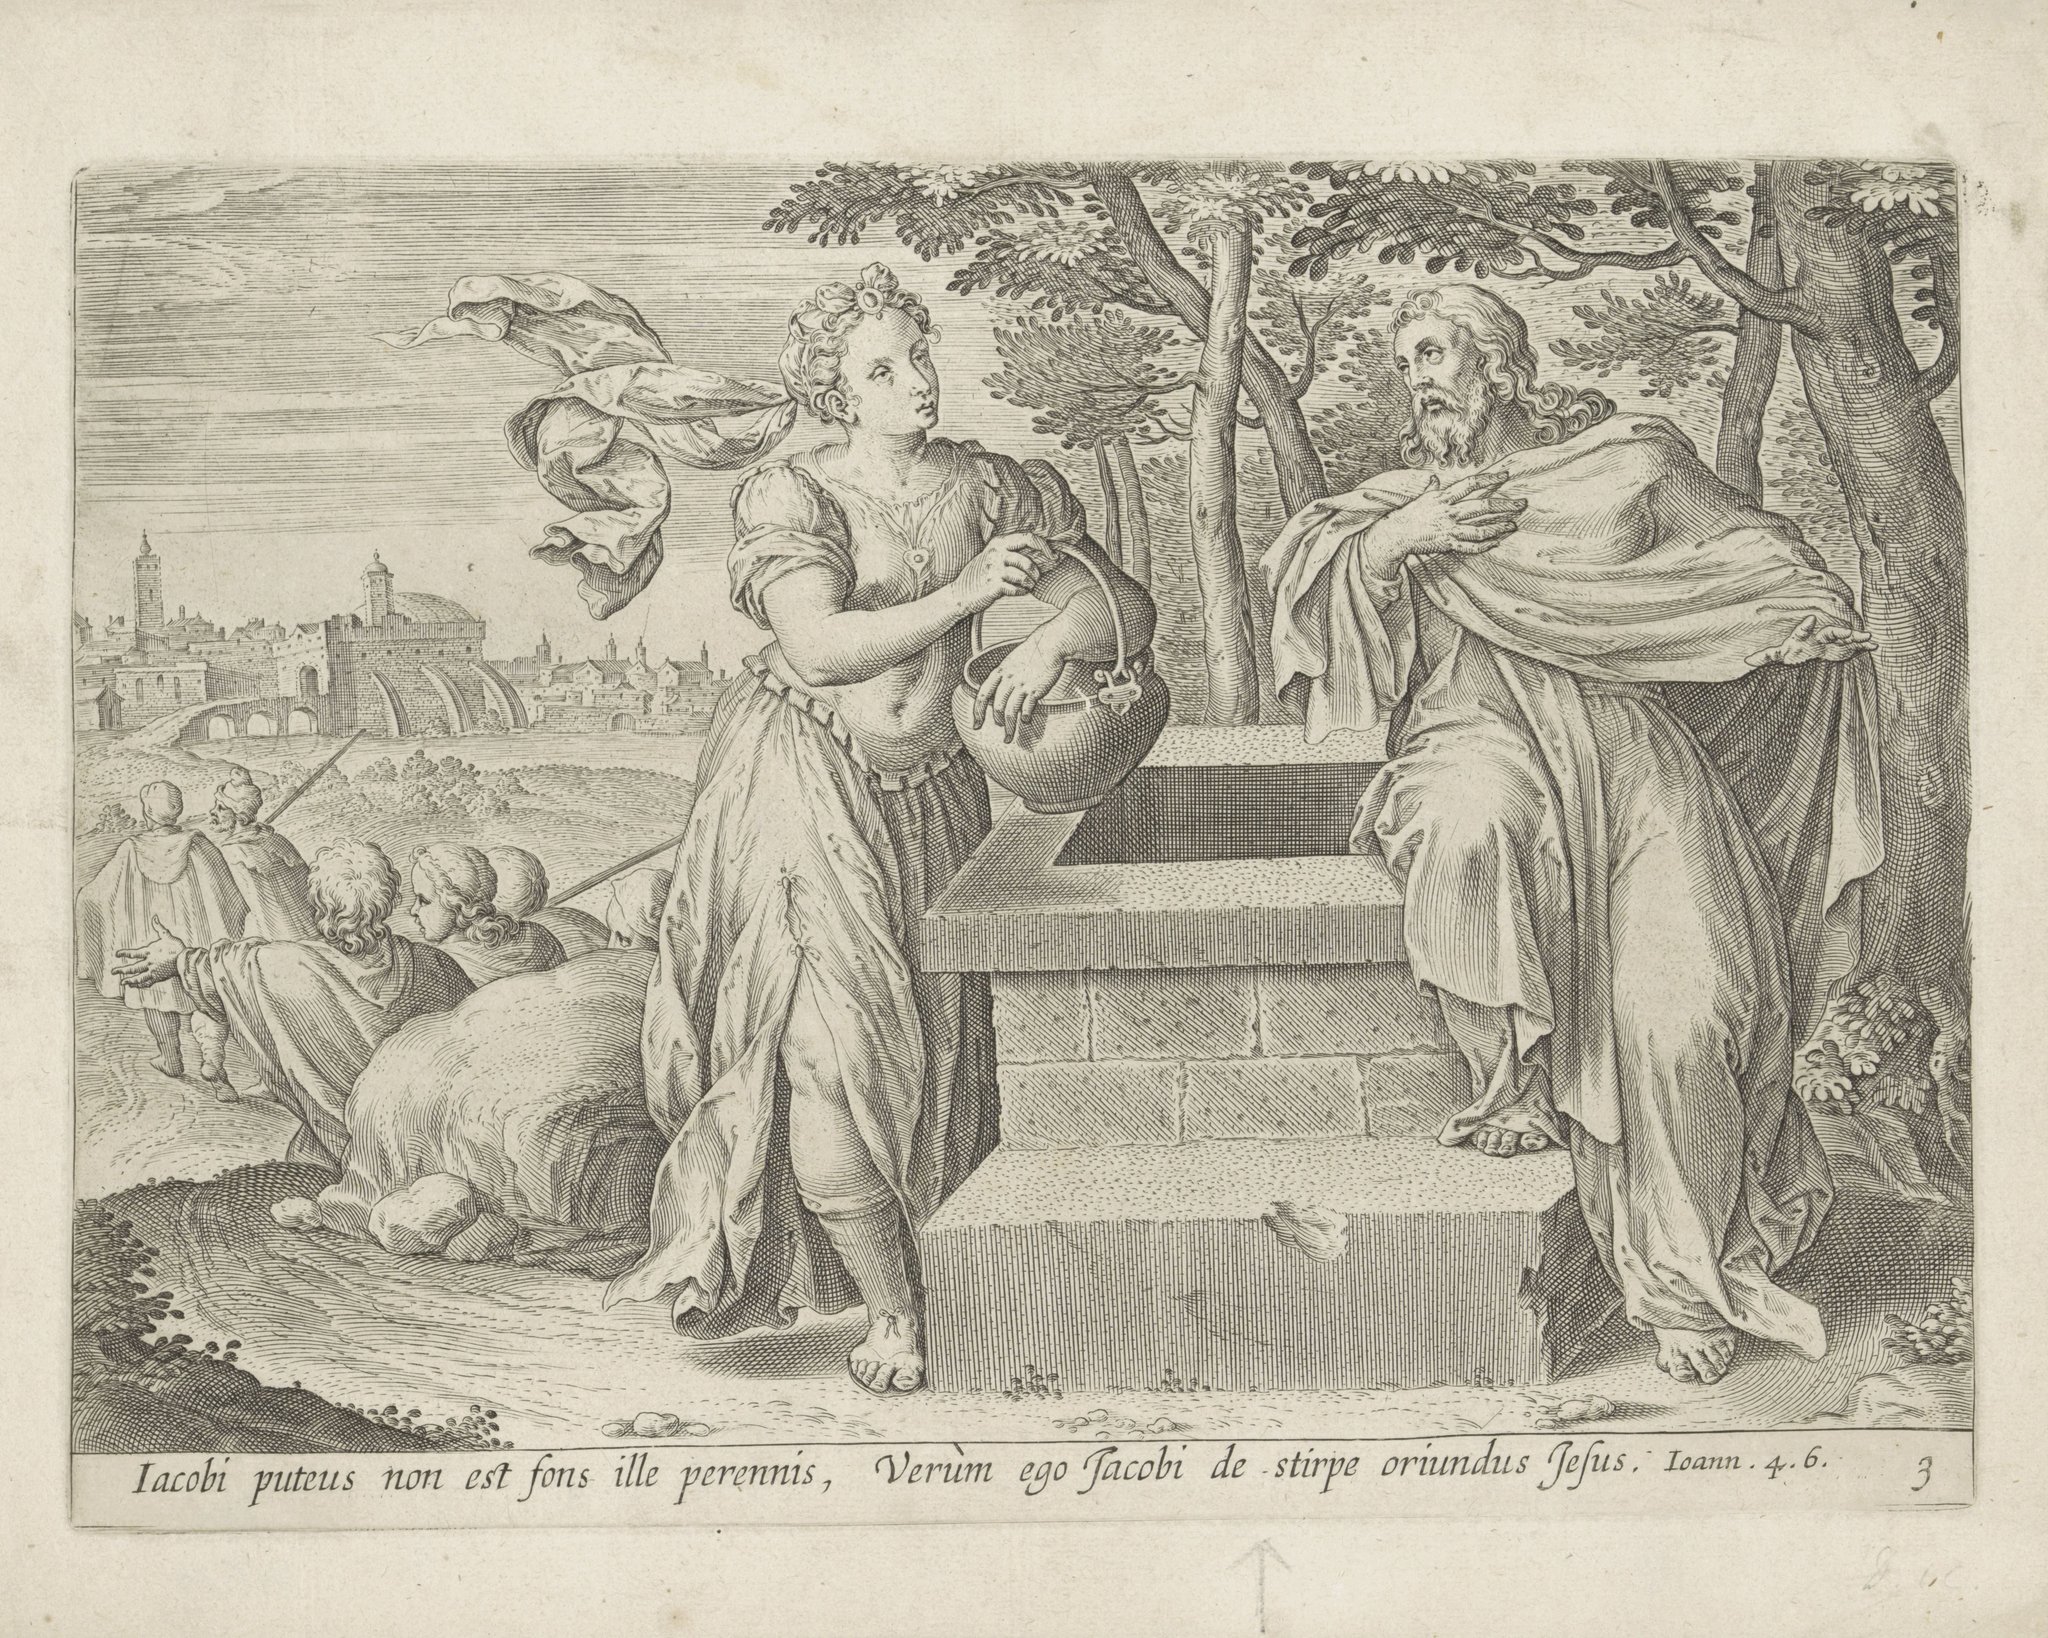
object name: print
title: Theatrum biblicum (...)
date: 1585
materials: paper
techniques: engraving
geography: amsterdam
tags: christ and the woman of samaria: sitting at jacob's well he asks her for a drink from her jug, christ resting at jacob's well, after having sent his disciples to sychar, utilitarian, public pump or water fountain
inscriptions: collector's mark: Lugt 2228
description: Christus rust bij de Jakobsbron, nadat hij zijn discipelen naar de stad heeft gestuurd. Links vertrekken zij richting de stad. Een Samaritaanse vrouw komt om water te putten en spreekt met Christus. Onder de voorstelling een verwijzing in het Latijn naar de Bijbeltekst in Joh. 4:6.